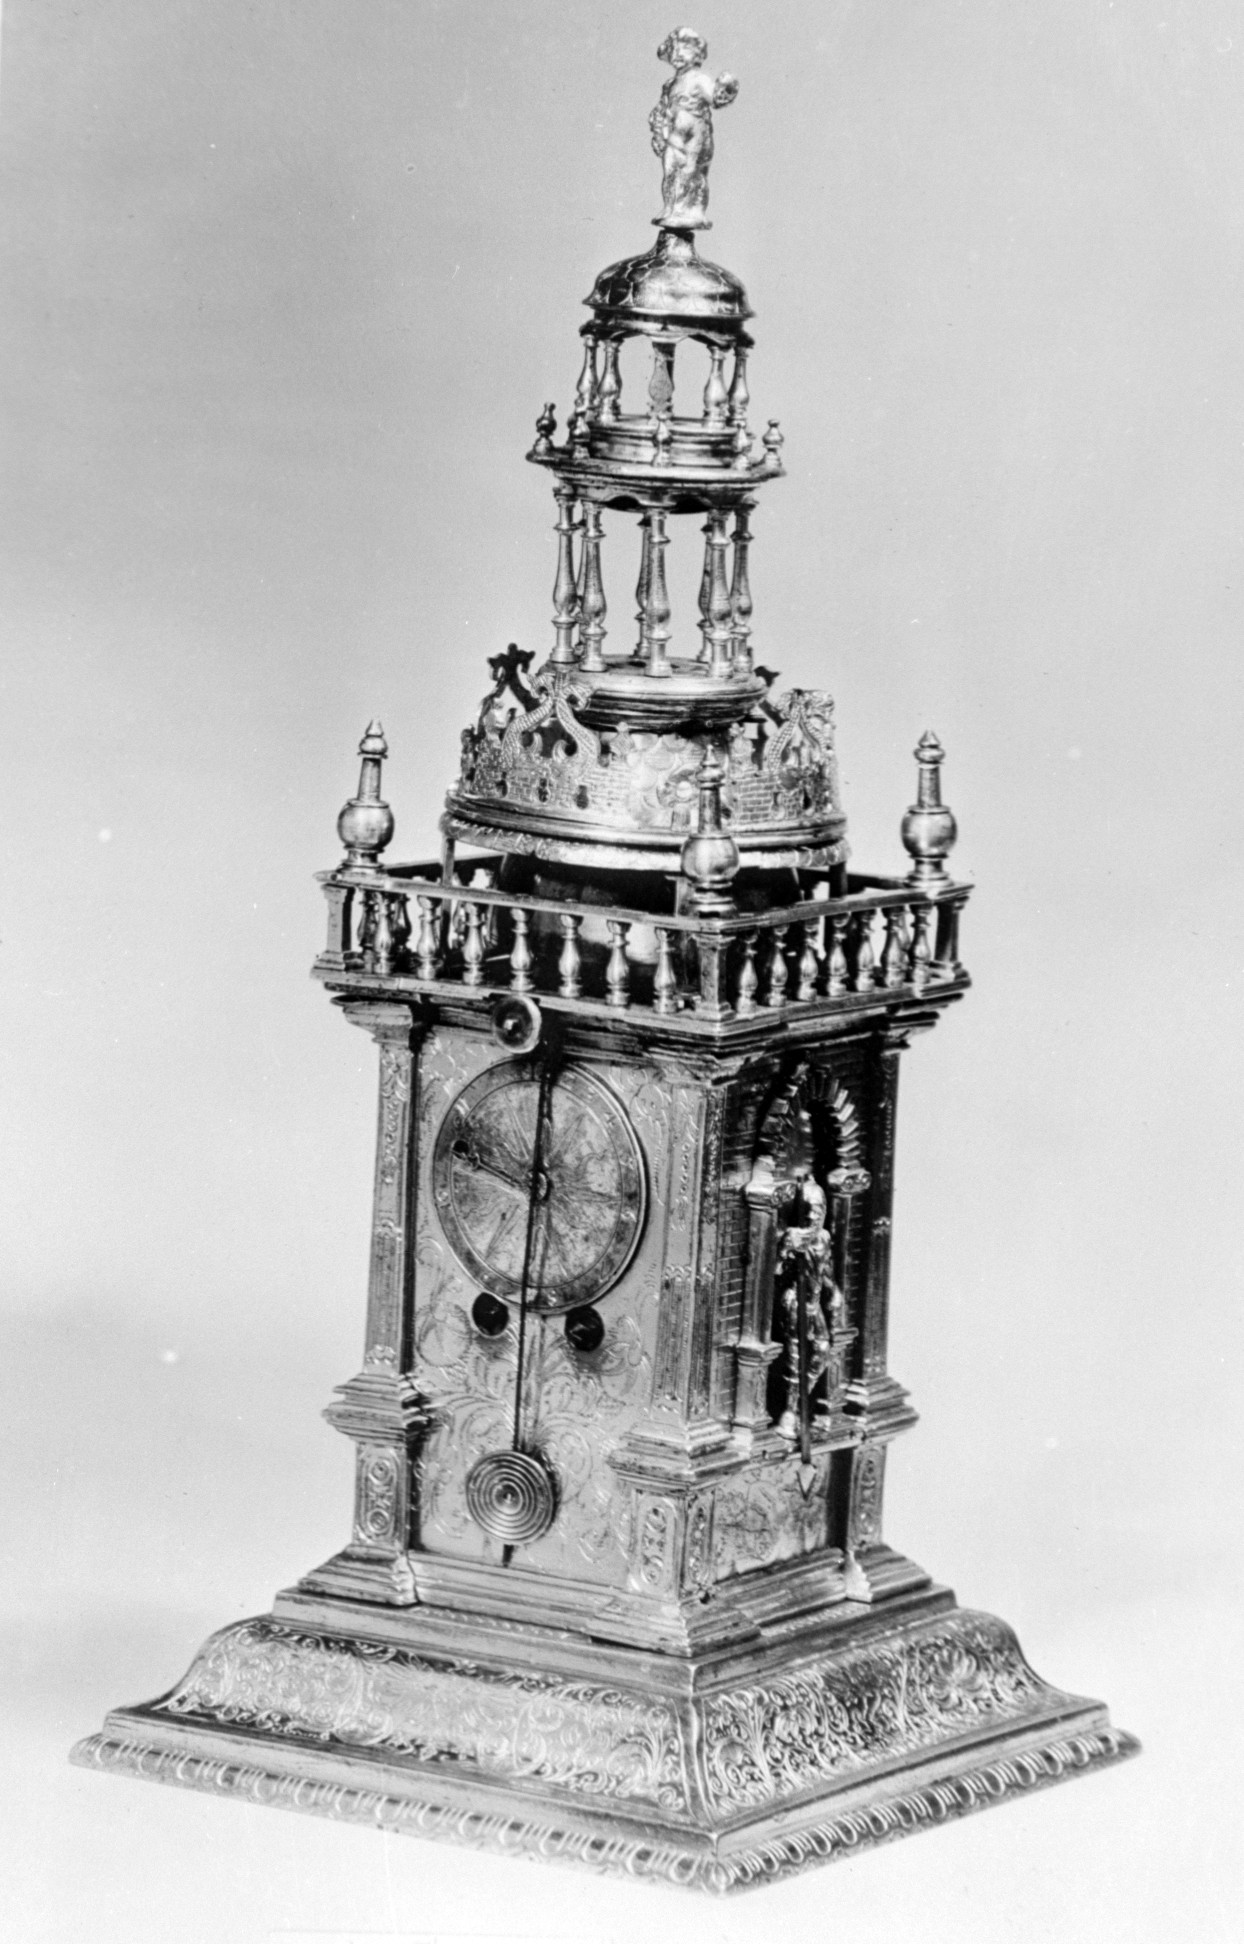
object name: table clock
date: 1567-1600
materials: gilt bronze